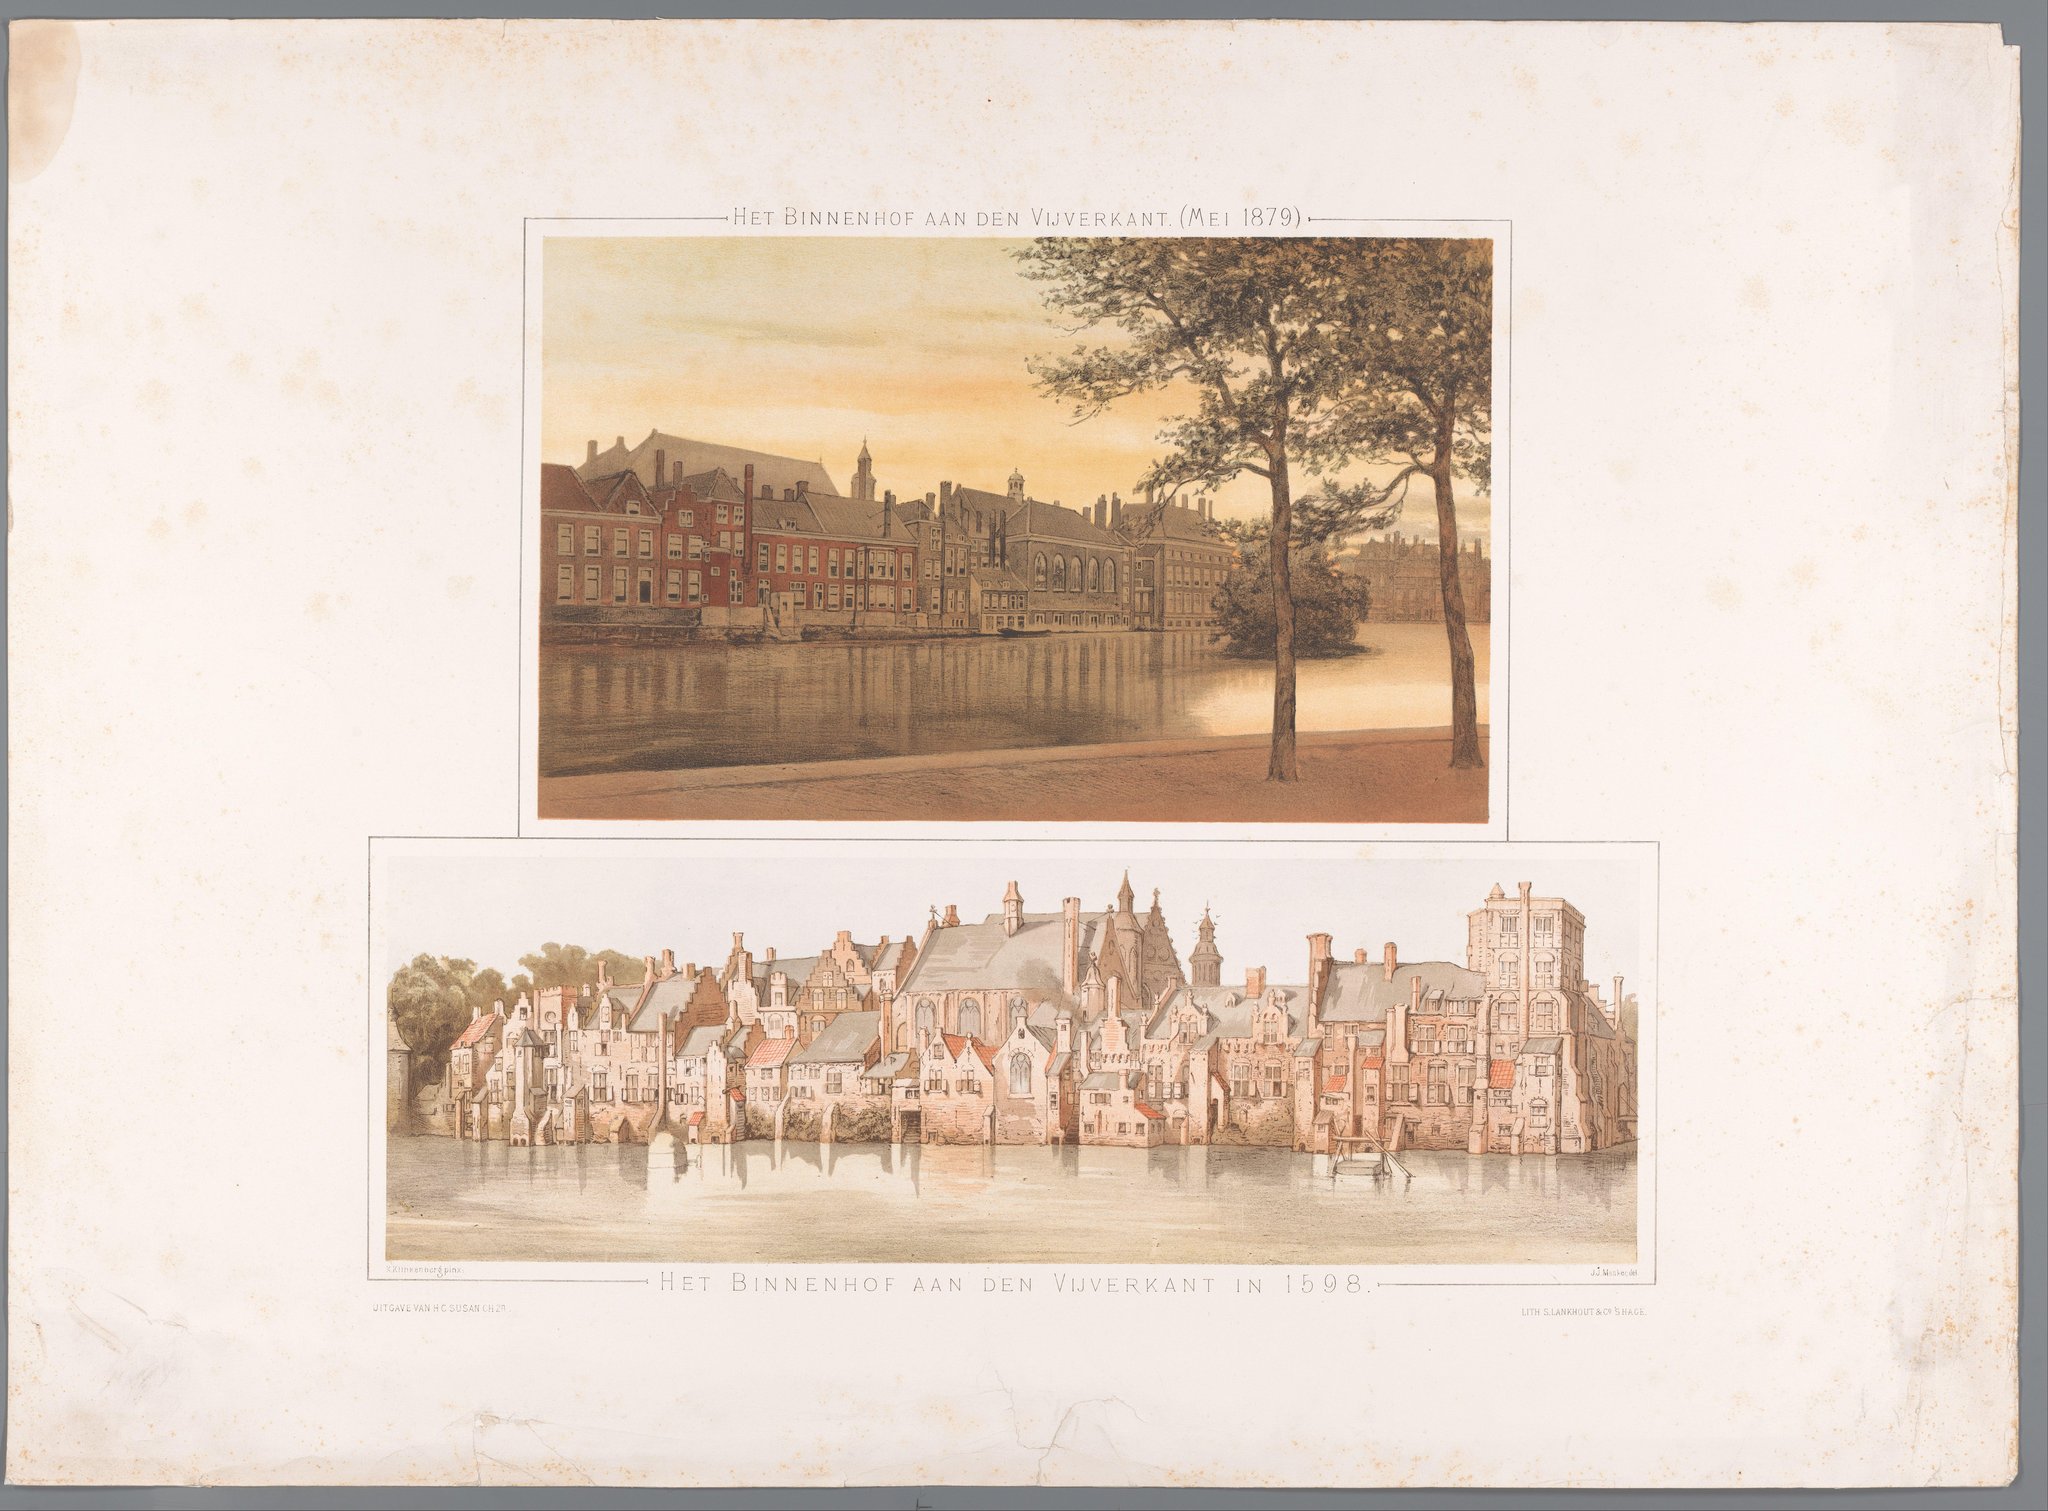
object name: print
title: Het Binnenhof aan den vijverkant in 1598 / Het Binnenhof aan den vijverkant (mei 1879)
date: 1879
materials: paper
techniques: lithograph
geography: the hague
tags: national government